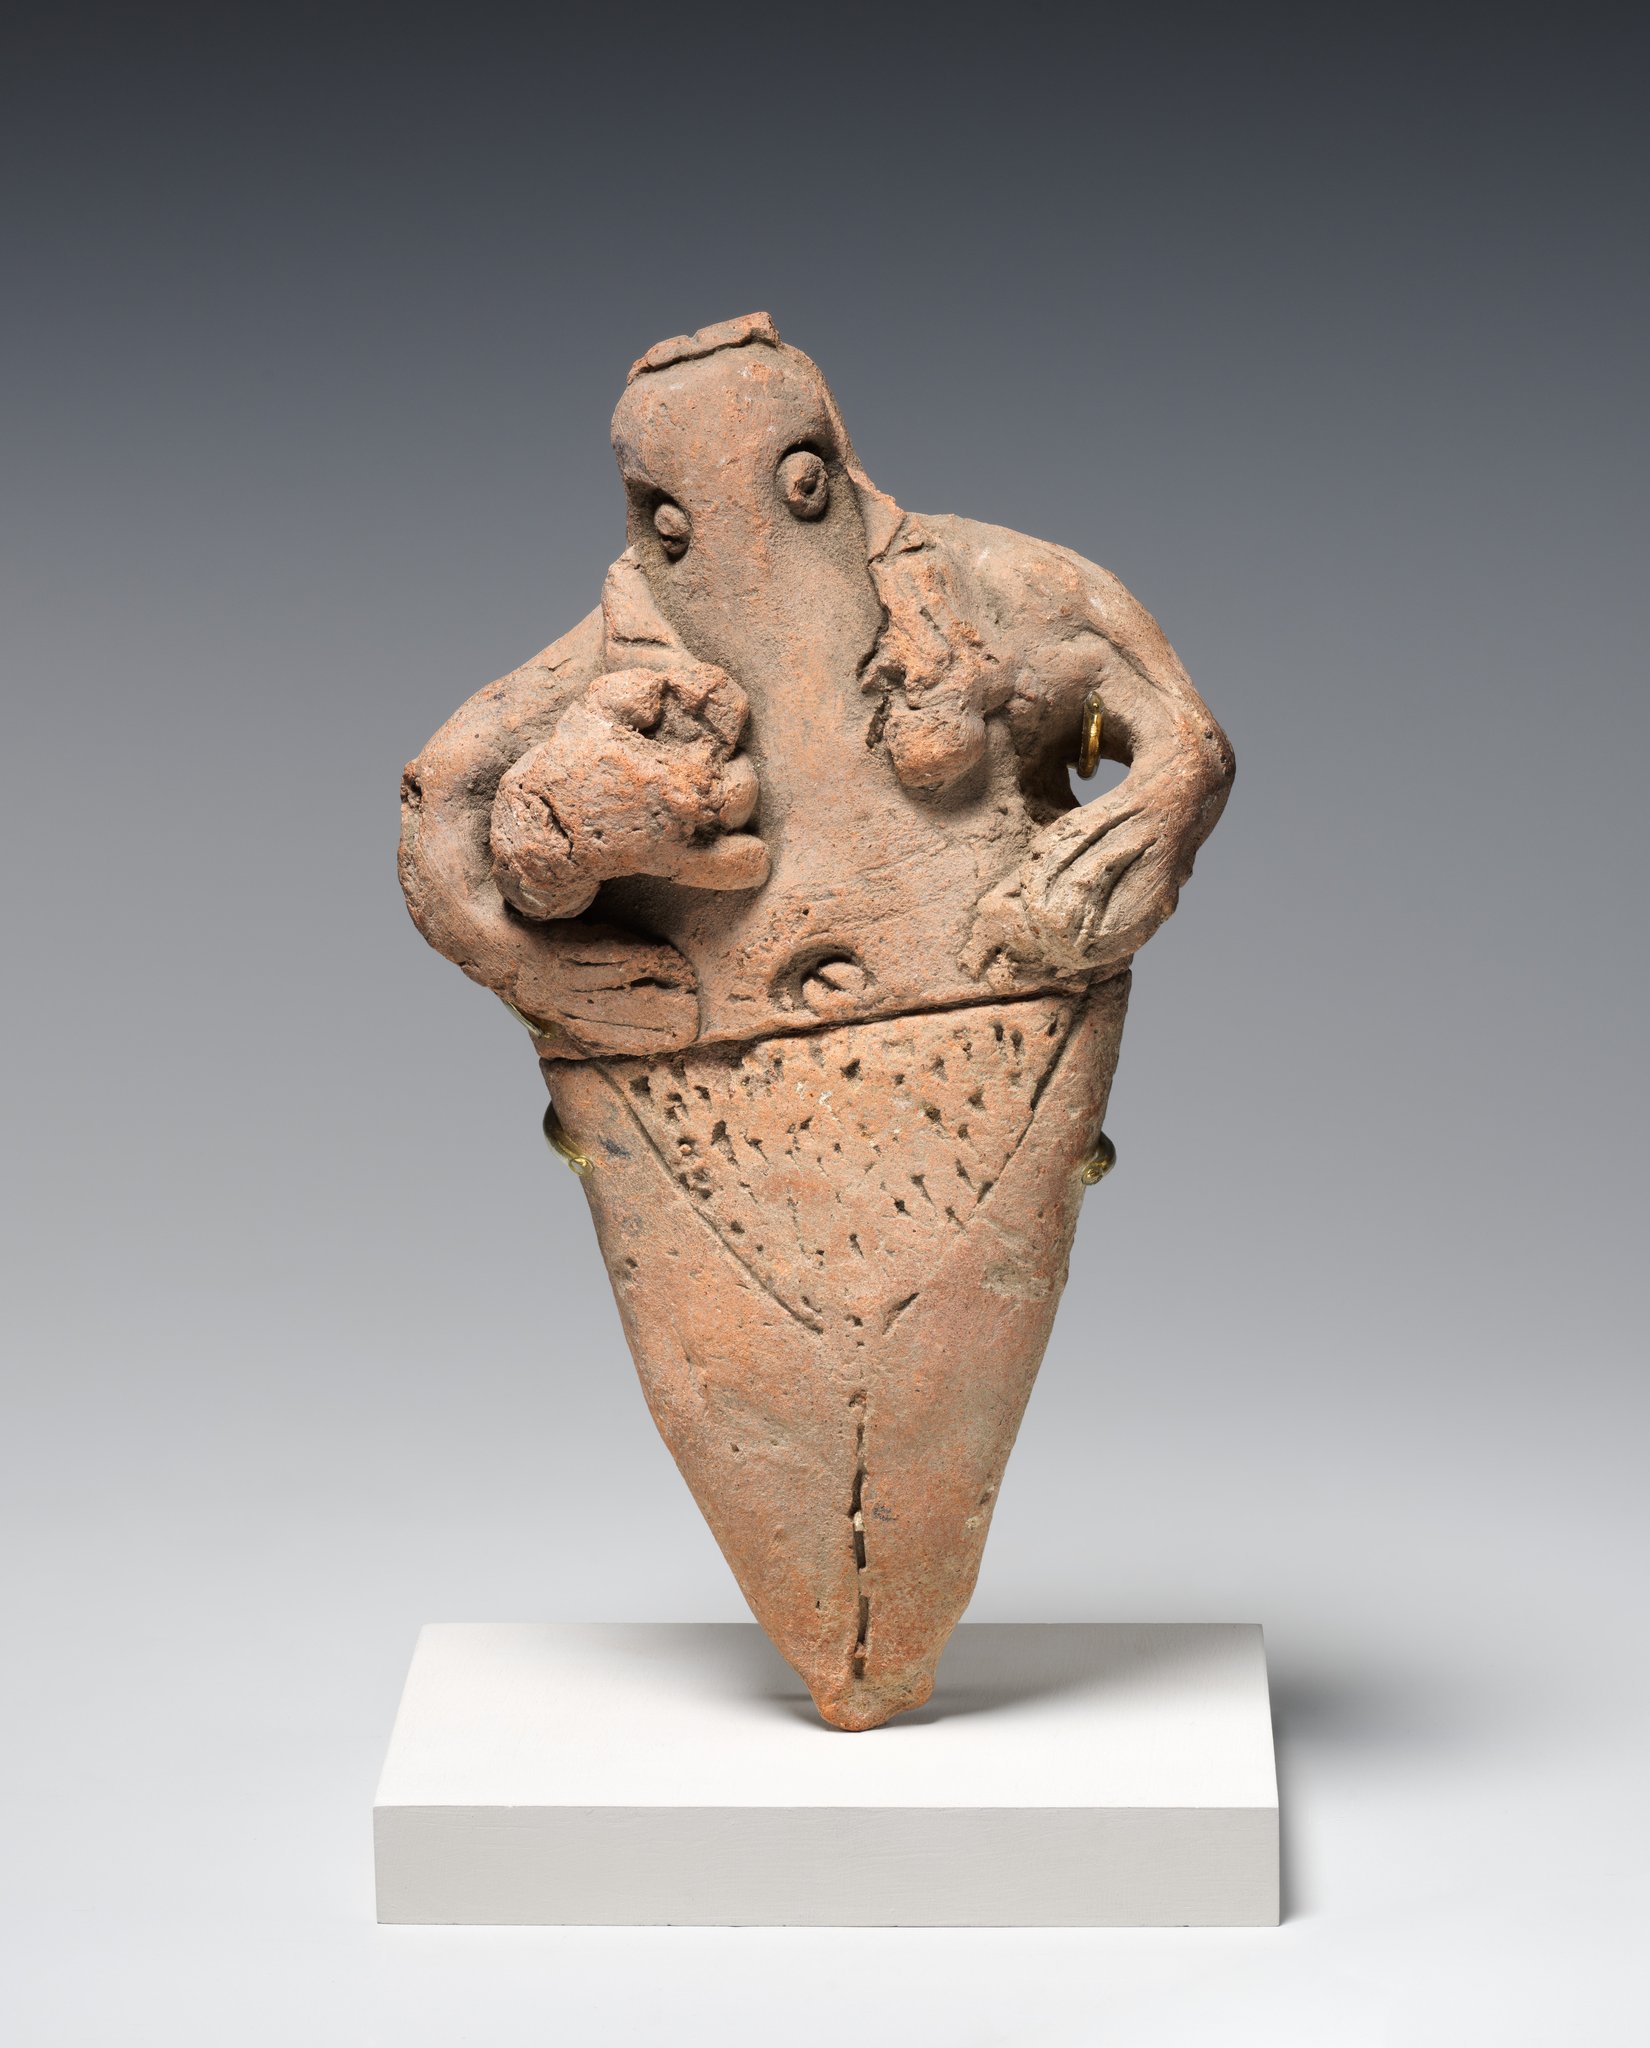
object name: figurine, nude woman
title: Female figure holding infant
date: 664-332 BCE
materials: terracotta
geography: egypt